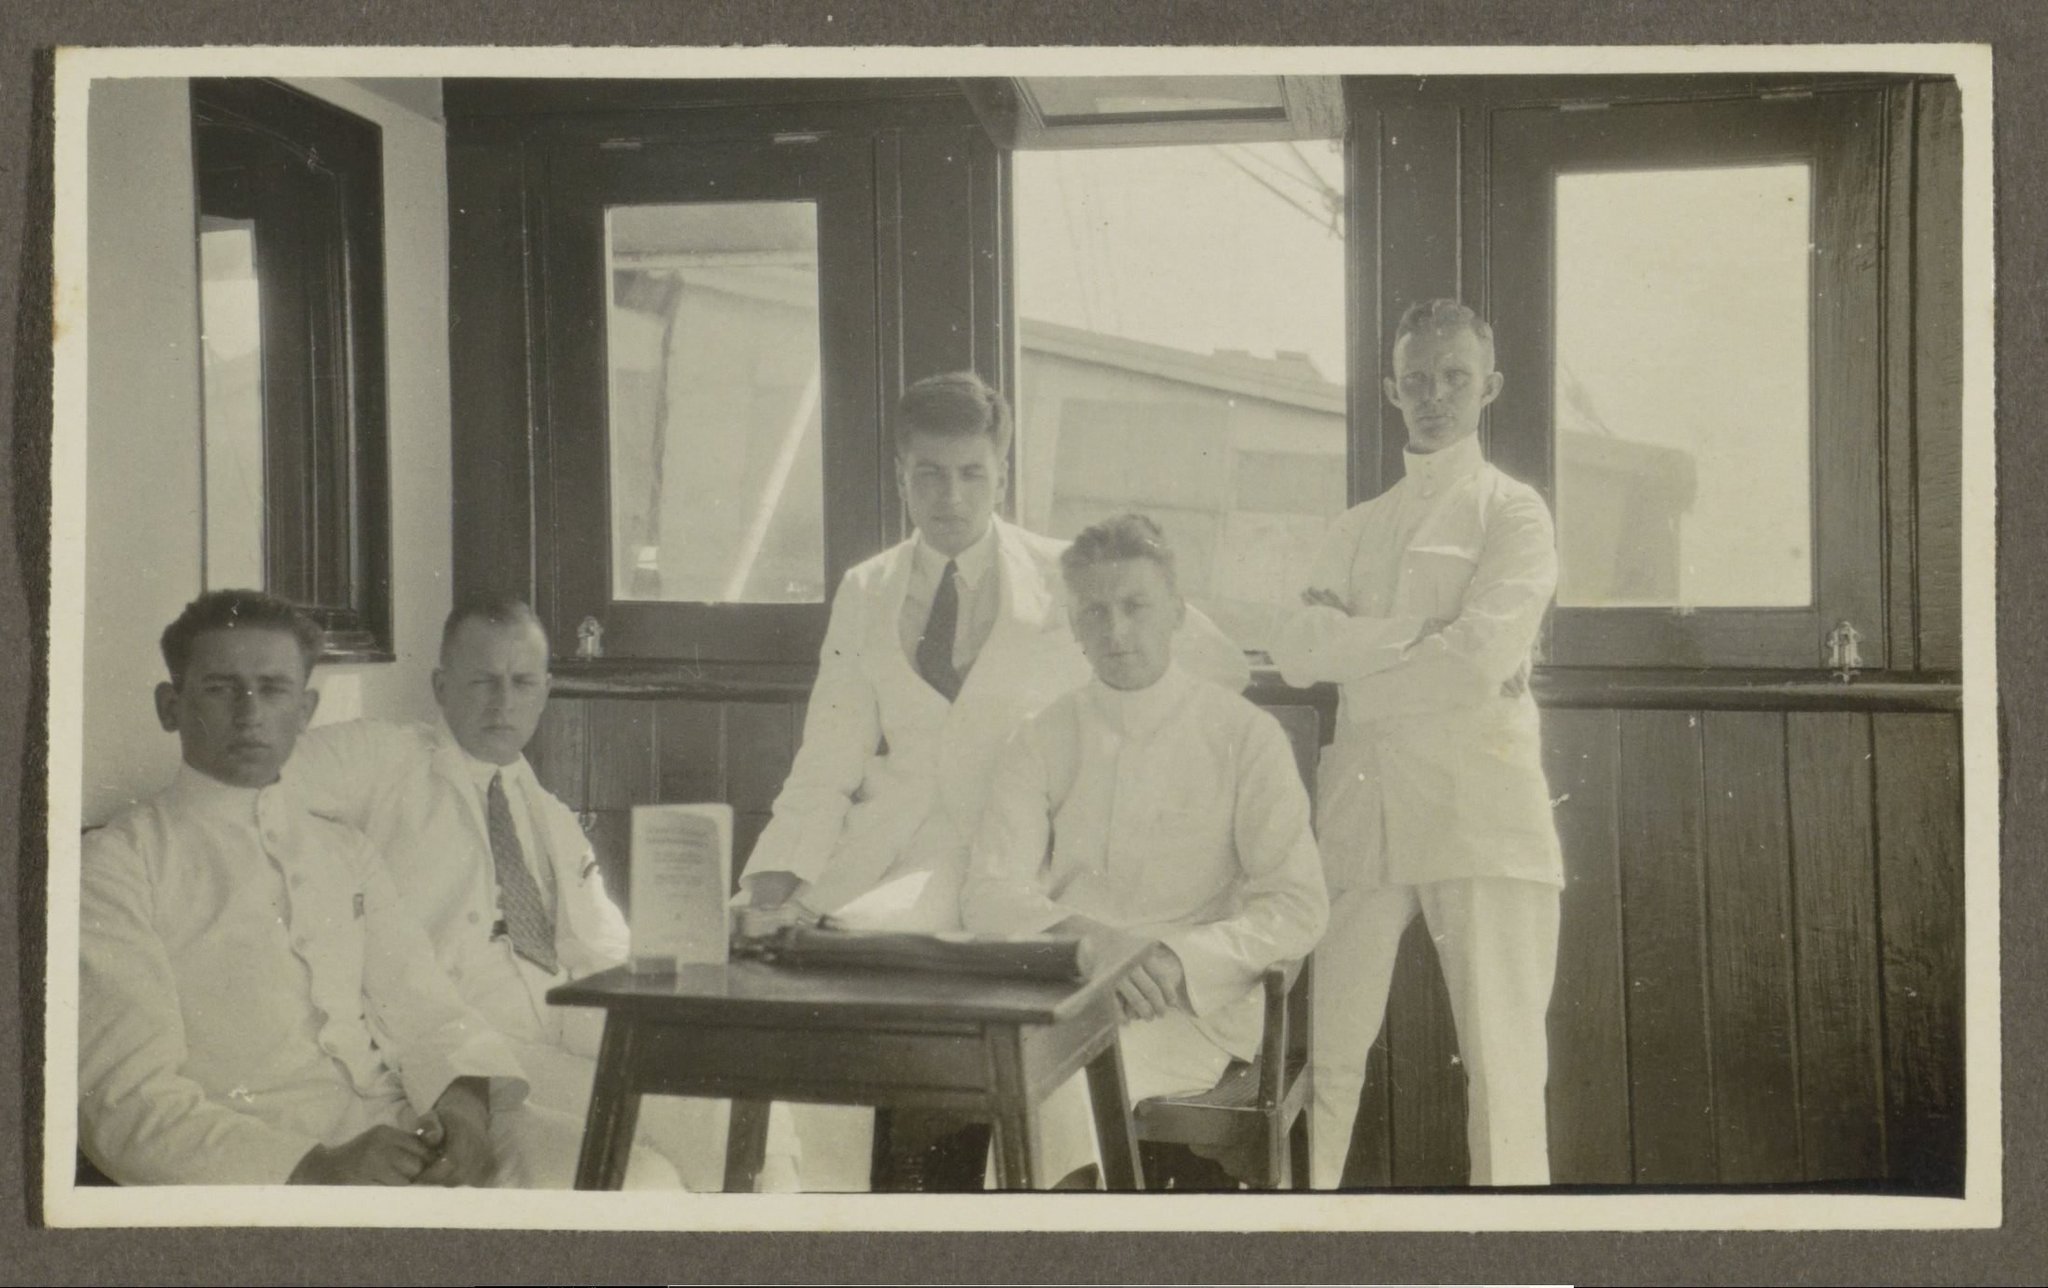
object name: photograph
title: Vijf mannen in tropenkledij zittend rondom een tafel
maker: Anonymous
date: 1920-1930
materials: photographic support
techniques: gelatin silver print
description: Onderdeel van familiealbum Nederlands-Indië.